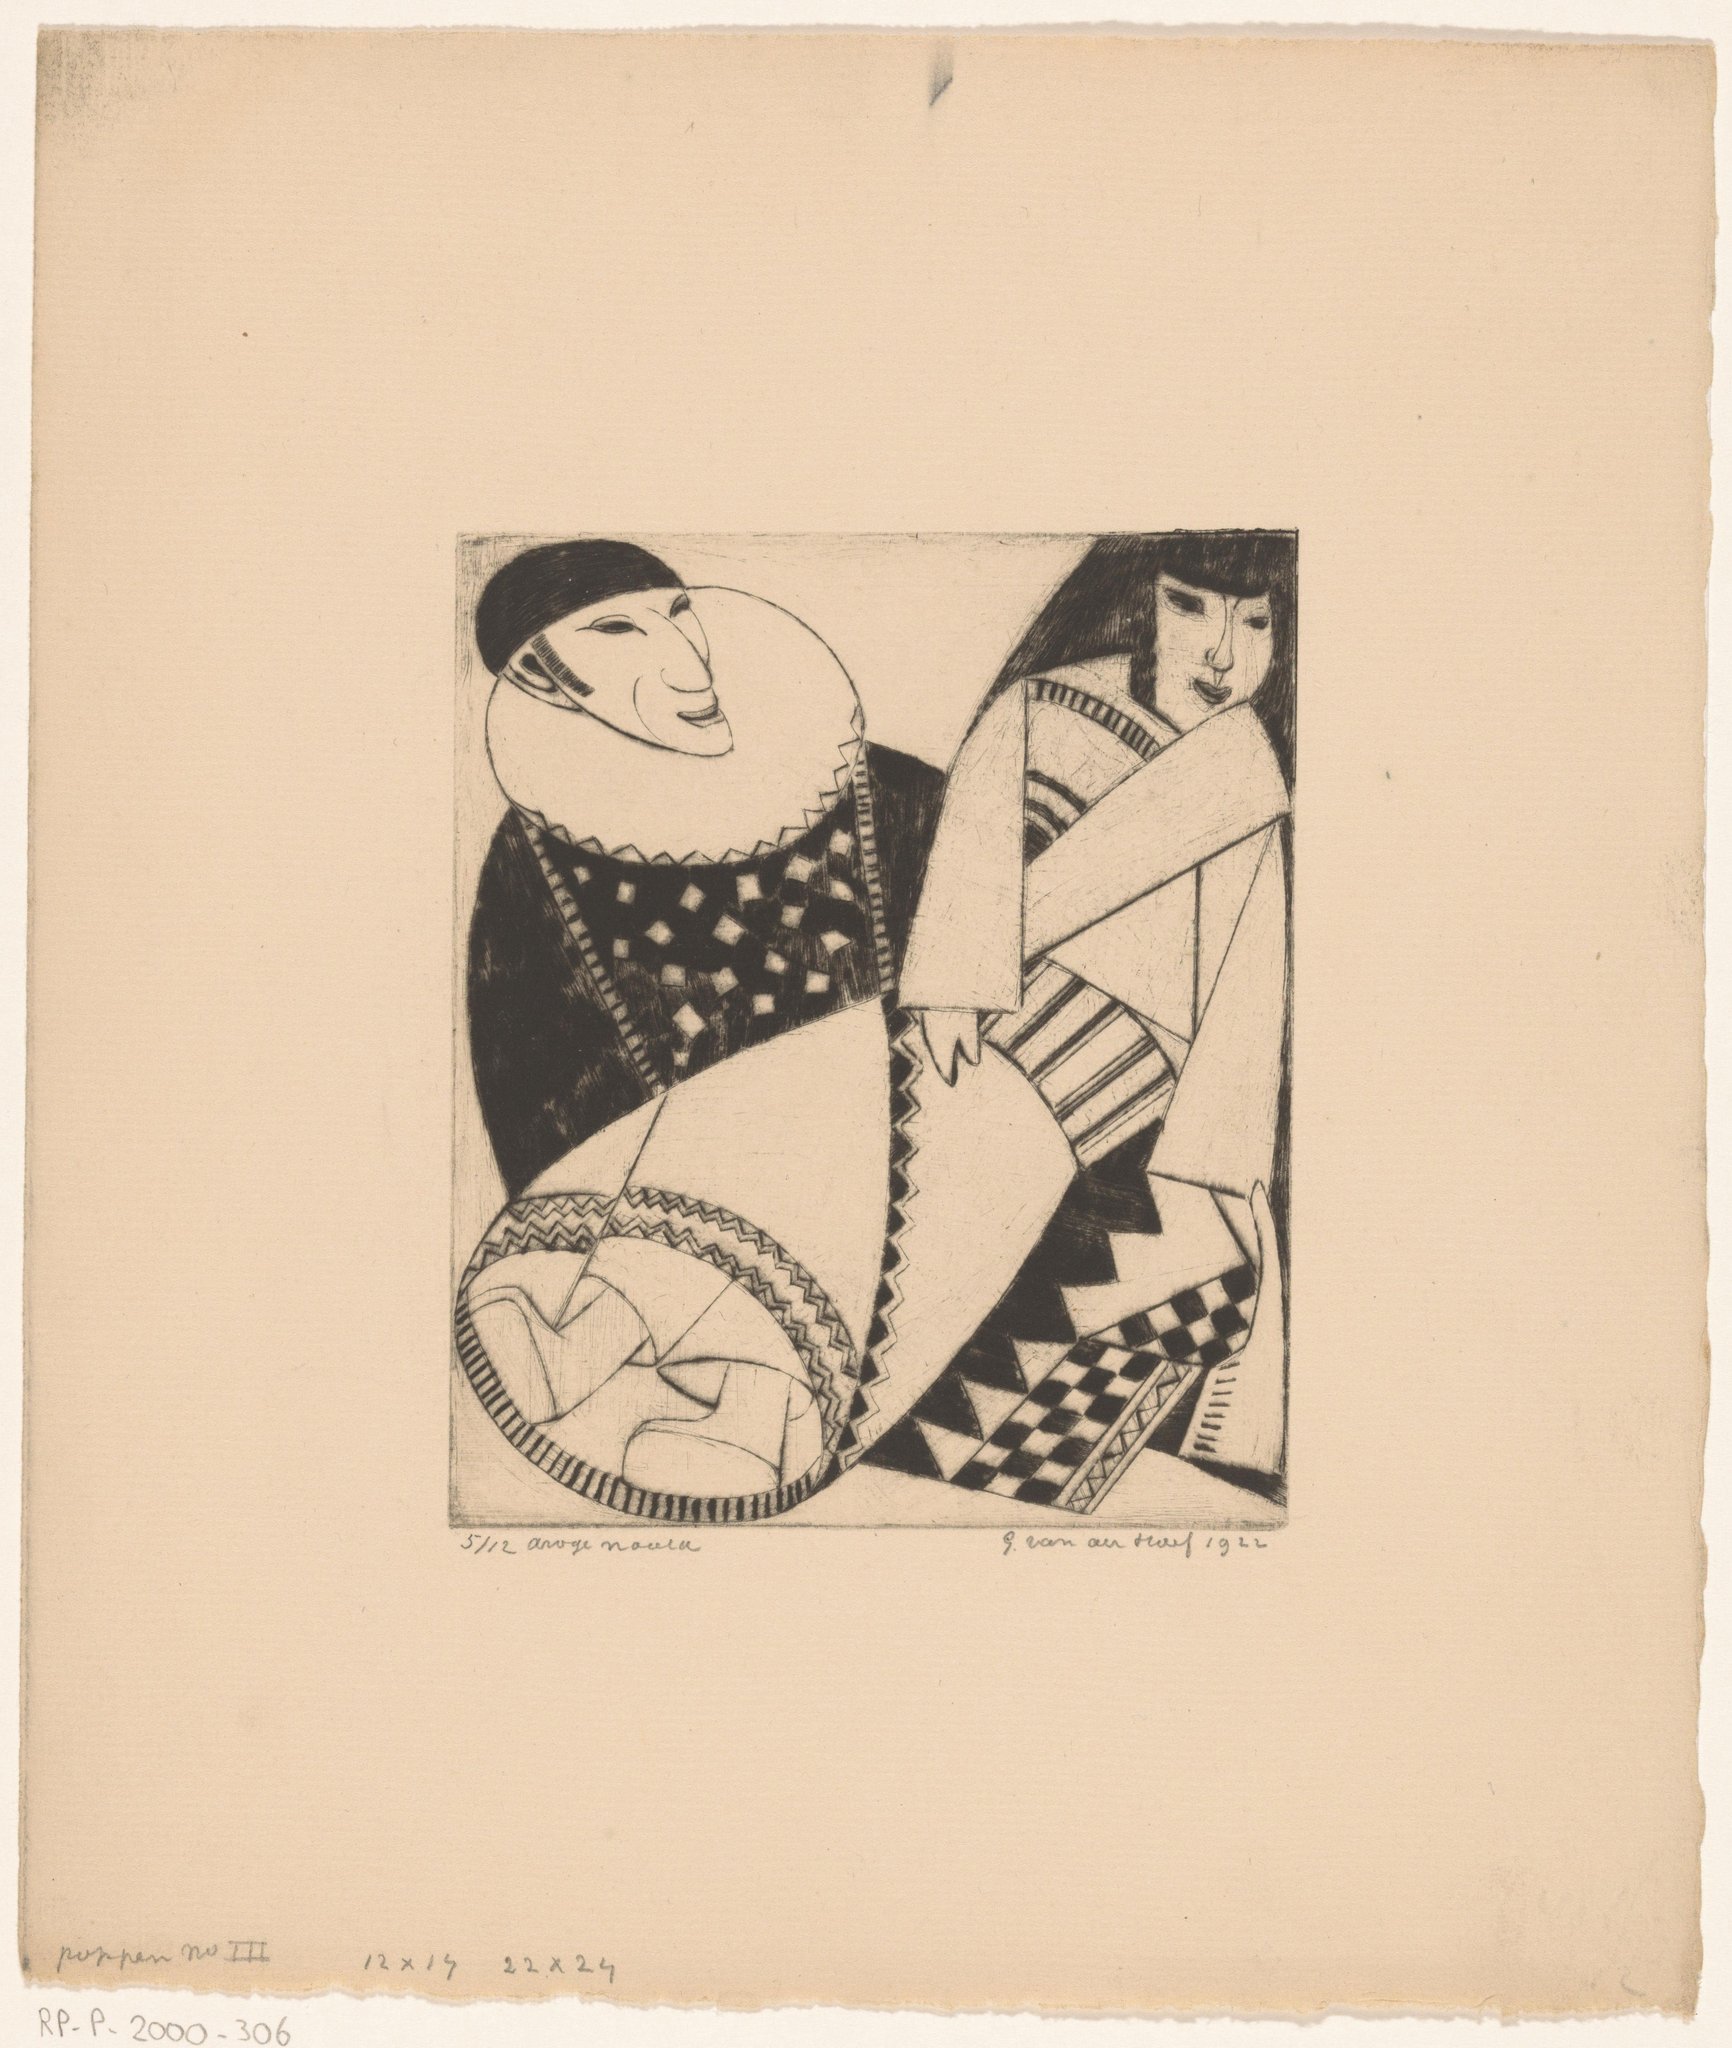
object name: print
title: Twee poppen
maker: gerrit van der hoef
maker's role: print maker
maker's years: 1879-1954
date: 1922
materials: paper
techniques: drypoint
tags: (playing with) dolls, types in 'commedia dell'arte': harlequin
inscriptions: collector's mark: Lugt 2228, collector's mark: ‘Ph. J.’, collector's mark: Lugt 2760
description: Links een lachende harlekijn en rechts een Japanse pop.